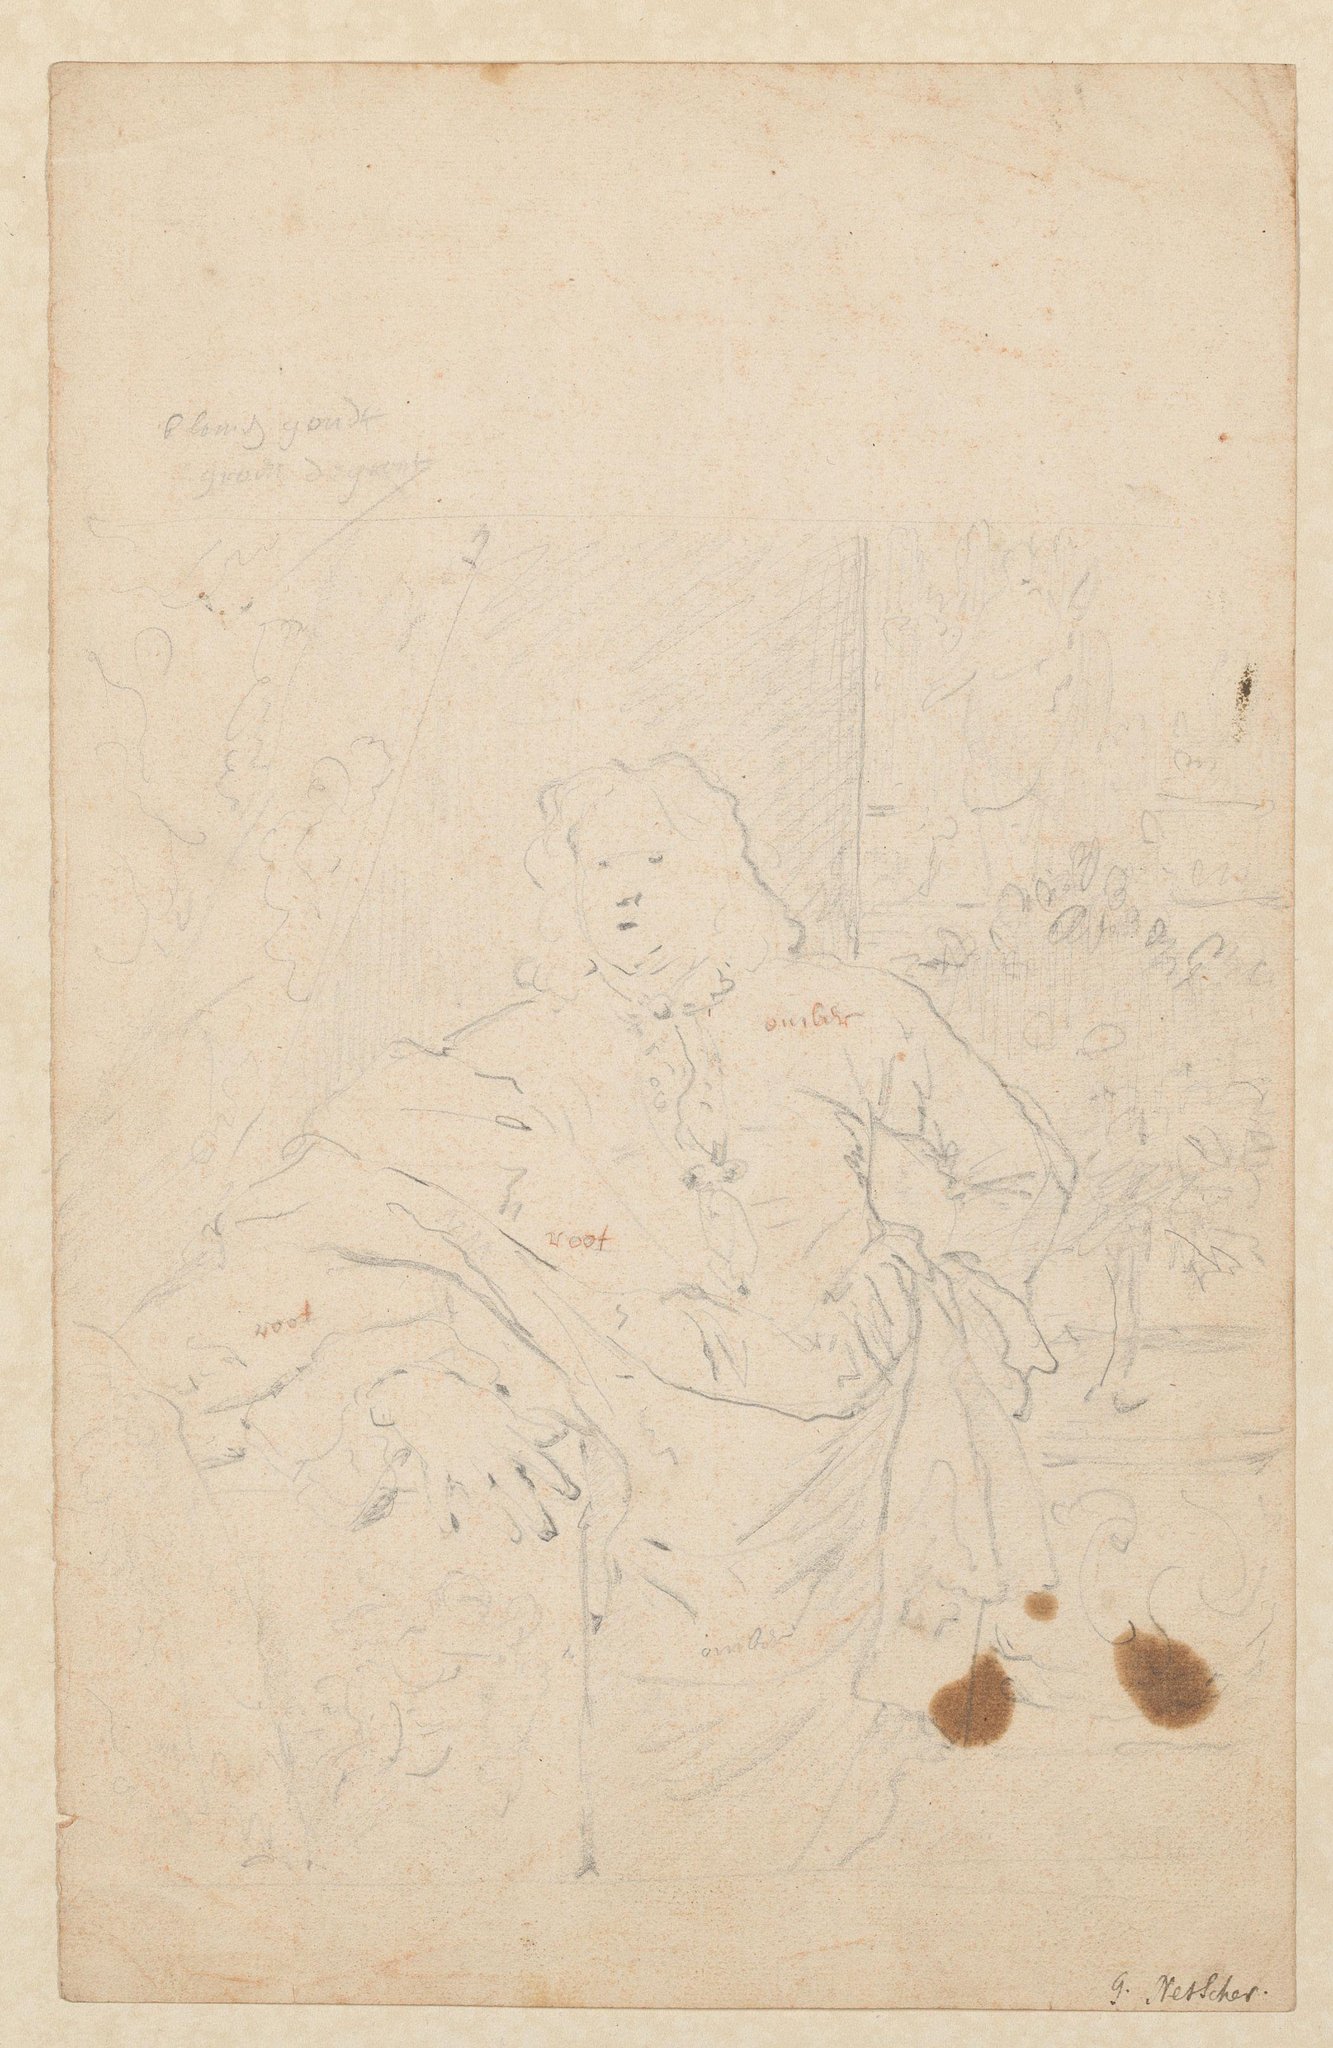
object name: album leaf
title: Portret van een man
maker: caspar netscher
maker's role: draughtsman, painter, print maker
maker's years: 1639-1684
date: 1649-1684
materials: chalk, paper, pencil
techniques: pasting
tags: landscapes, historical persons not known by name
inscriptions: inscription: ‘bloemen goudt/ groen de gront’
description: In sommige vlakken zijn kleuraanwijzingen geschreven. Tekening maakt deel uit van een album.